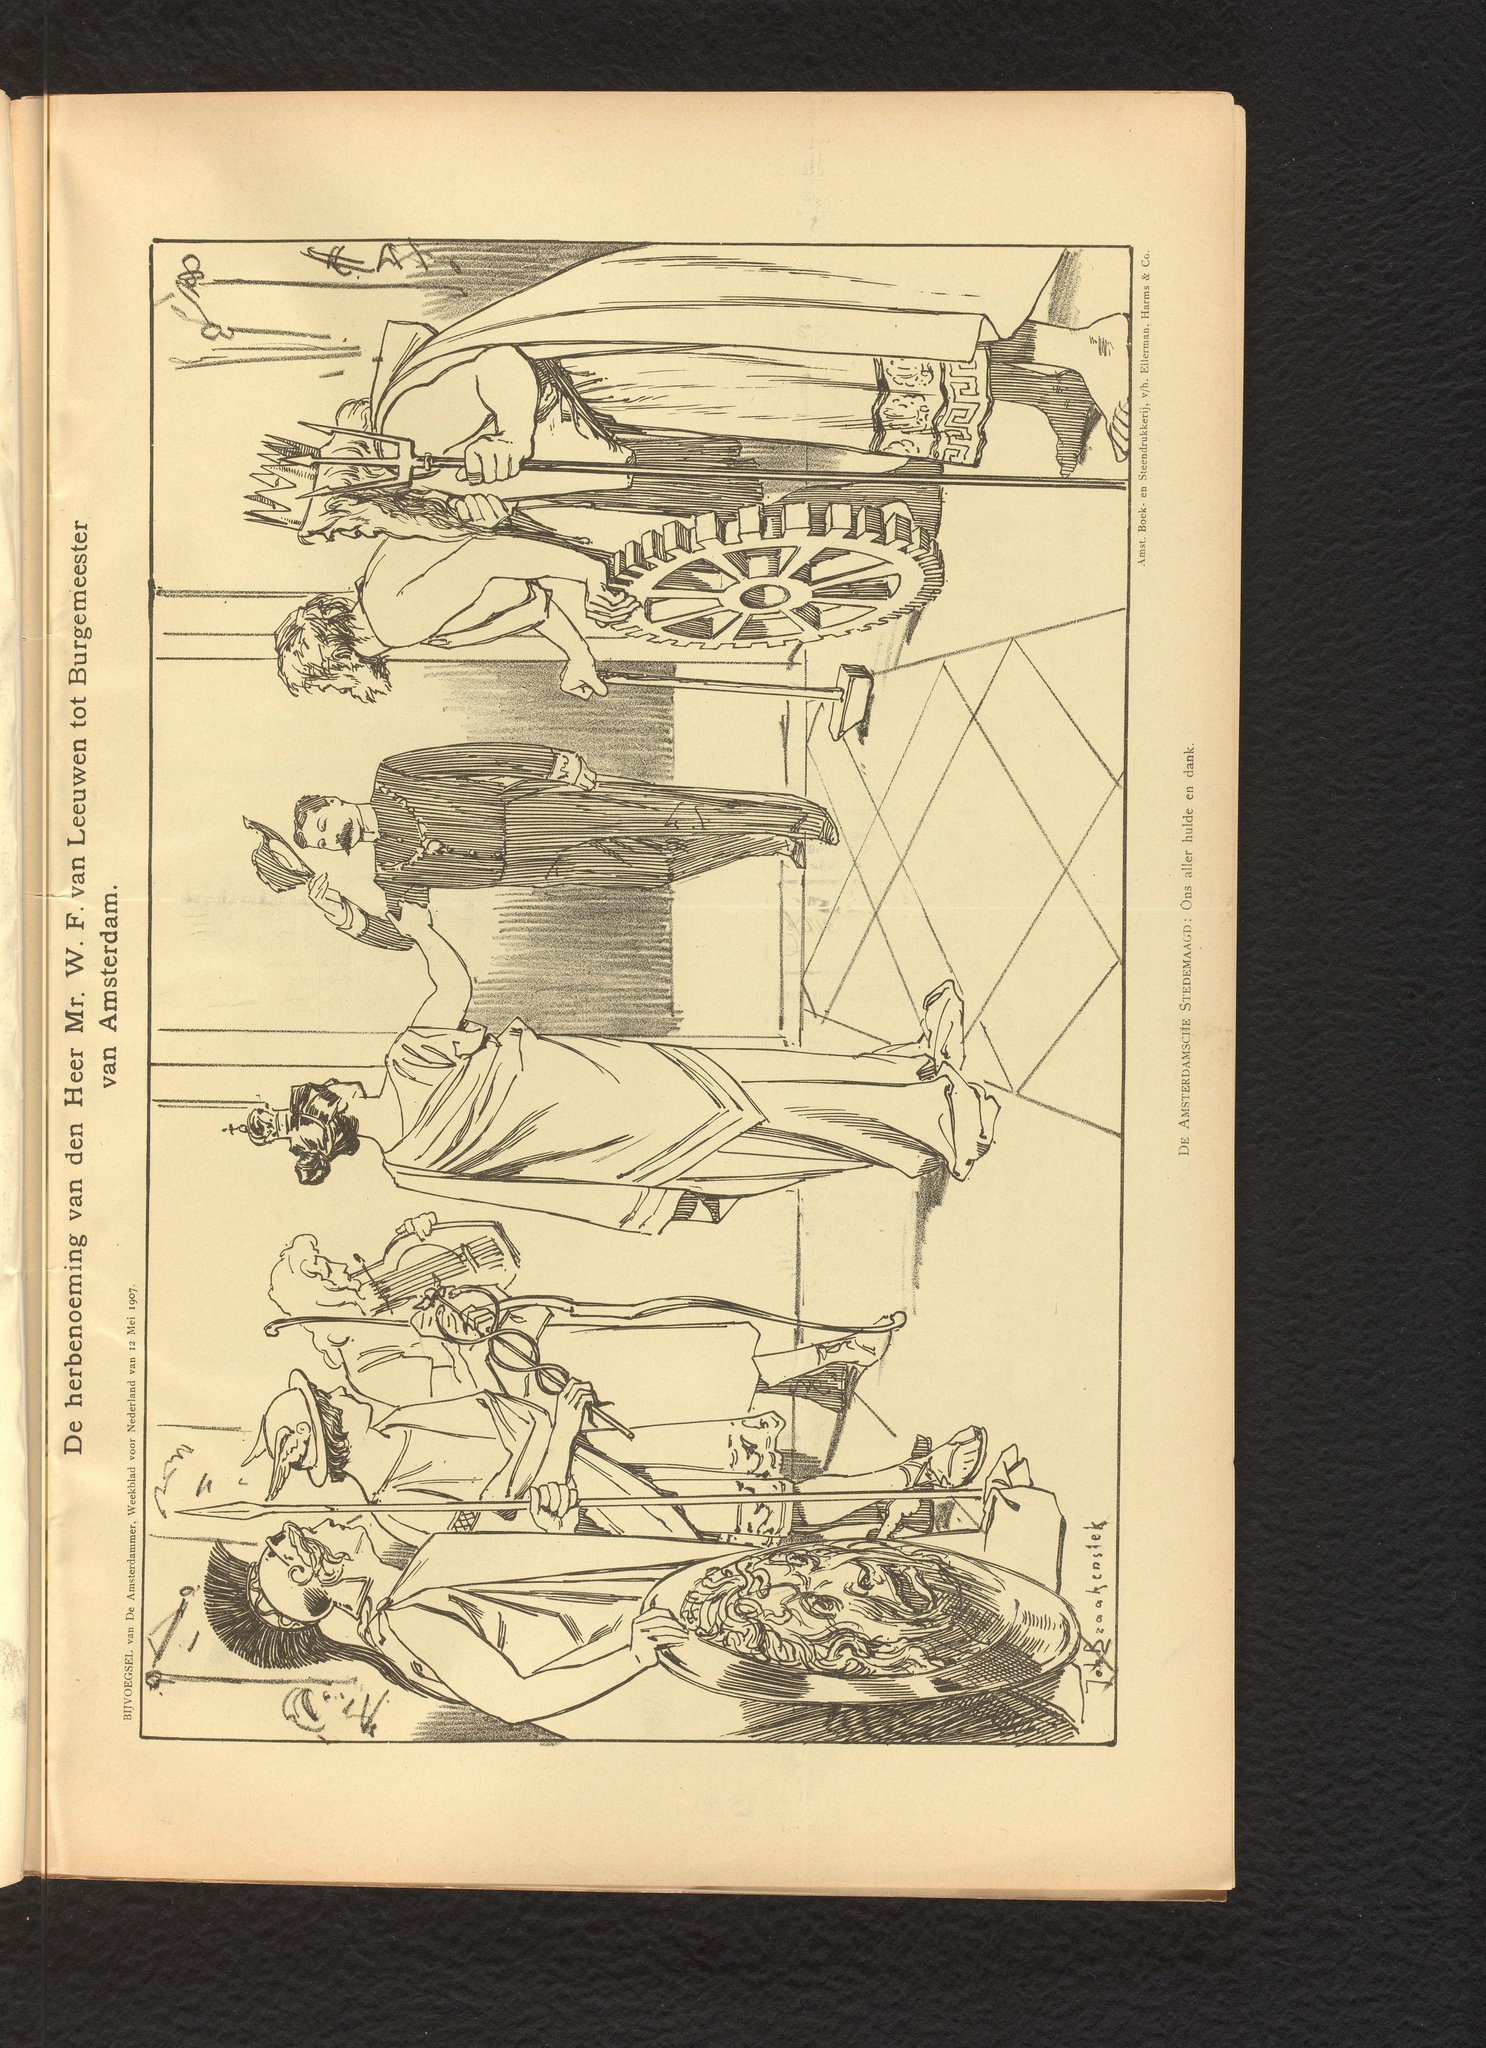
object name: cartoon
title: Een Spaansch-Engelsche idylle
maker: johan braakensiek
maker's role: draughtsman, print maker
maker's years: 1858-1940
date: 1907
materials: paper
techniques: lithograph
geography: amsterdam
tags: visiting the new mother, lying-in visit, political caricatures and satires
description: De Britse koning Edward VII op kraambezoek bij de Spaanse koning Alfons XIII en zijn vrouw, de van oorsprong Engelse Victoria Eugénie van Battenberg. Bij de geboorte van de kroonprins Alfons van Bourbon op 10 mei 1907.